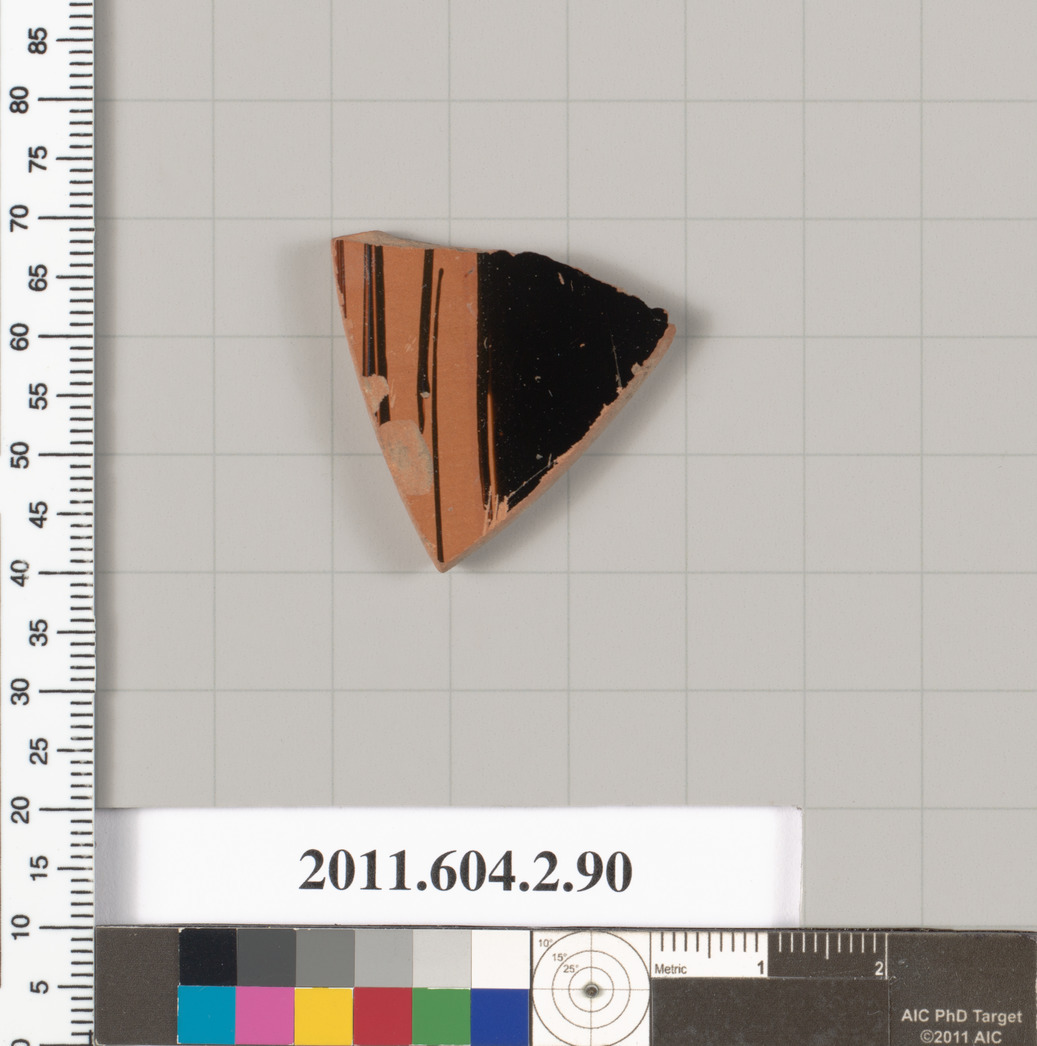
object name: pelike fragment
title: Terracotta fragment of a pelike (jar)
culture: greek, attic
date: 490-470 BCE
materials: terracotta